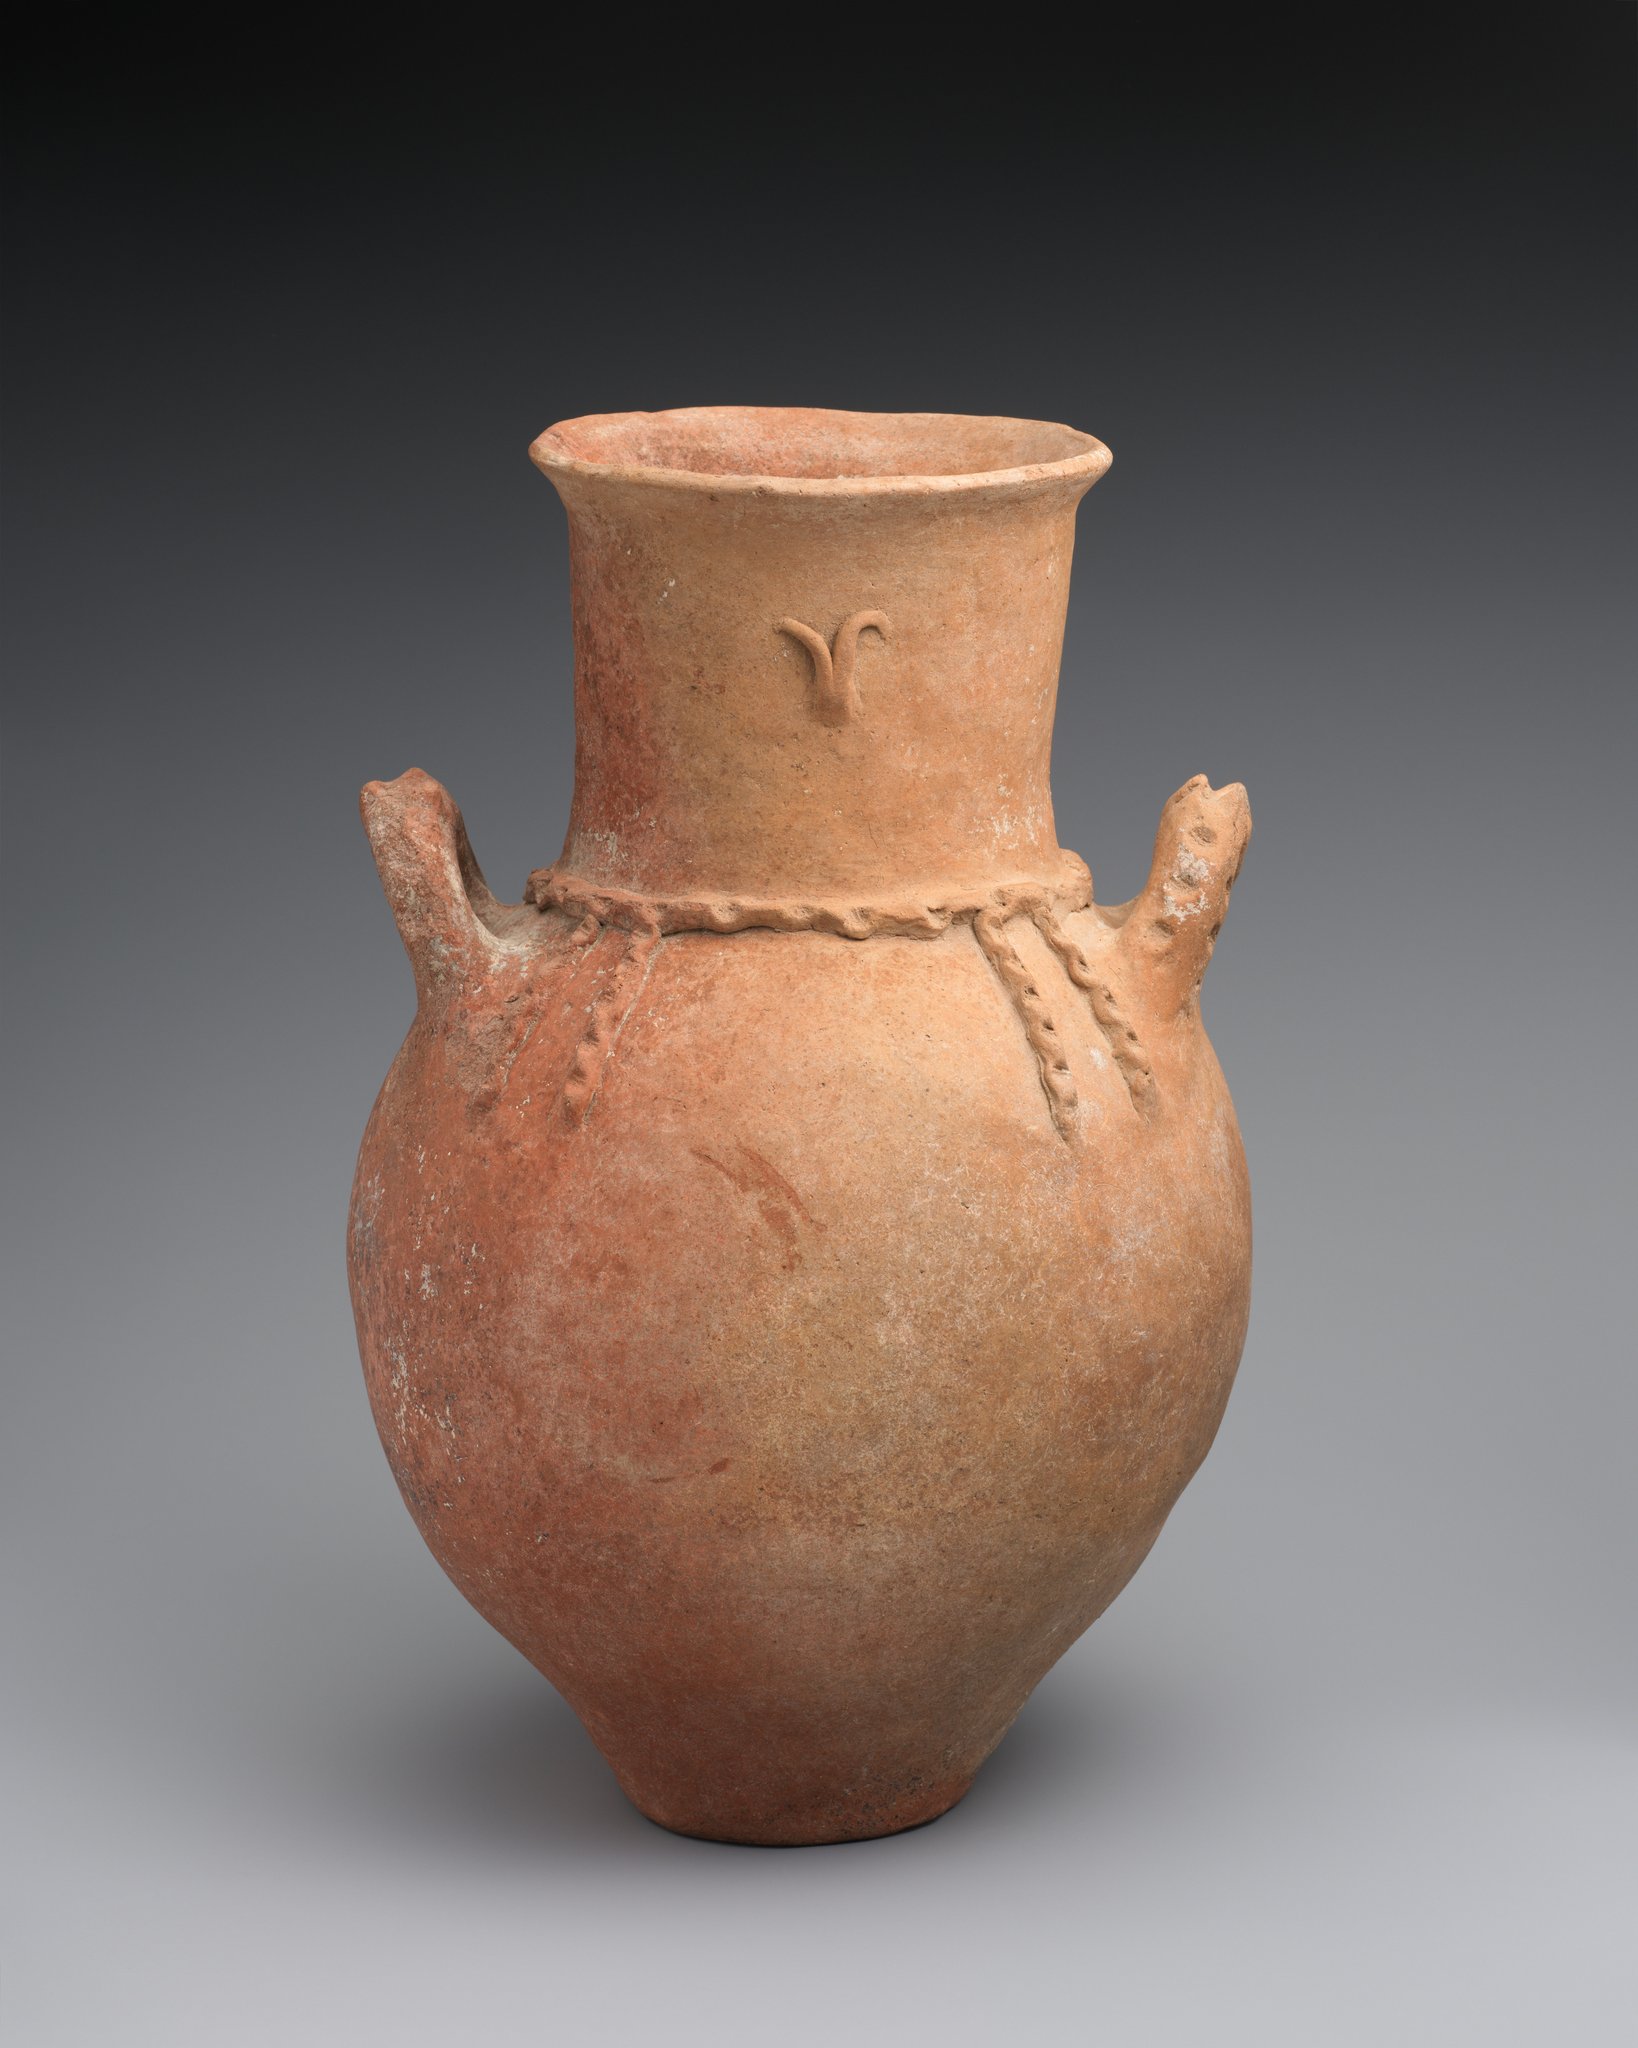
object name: amphora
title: Terracotta amphora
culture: cypriot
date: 1900-1600 BCE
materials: terracotta